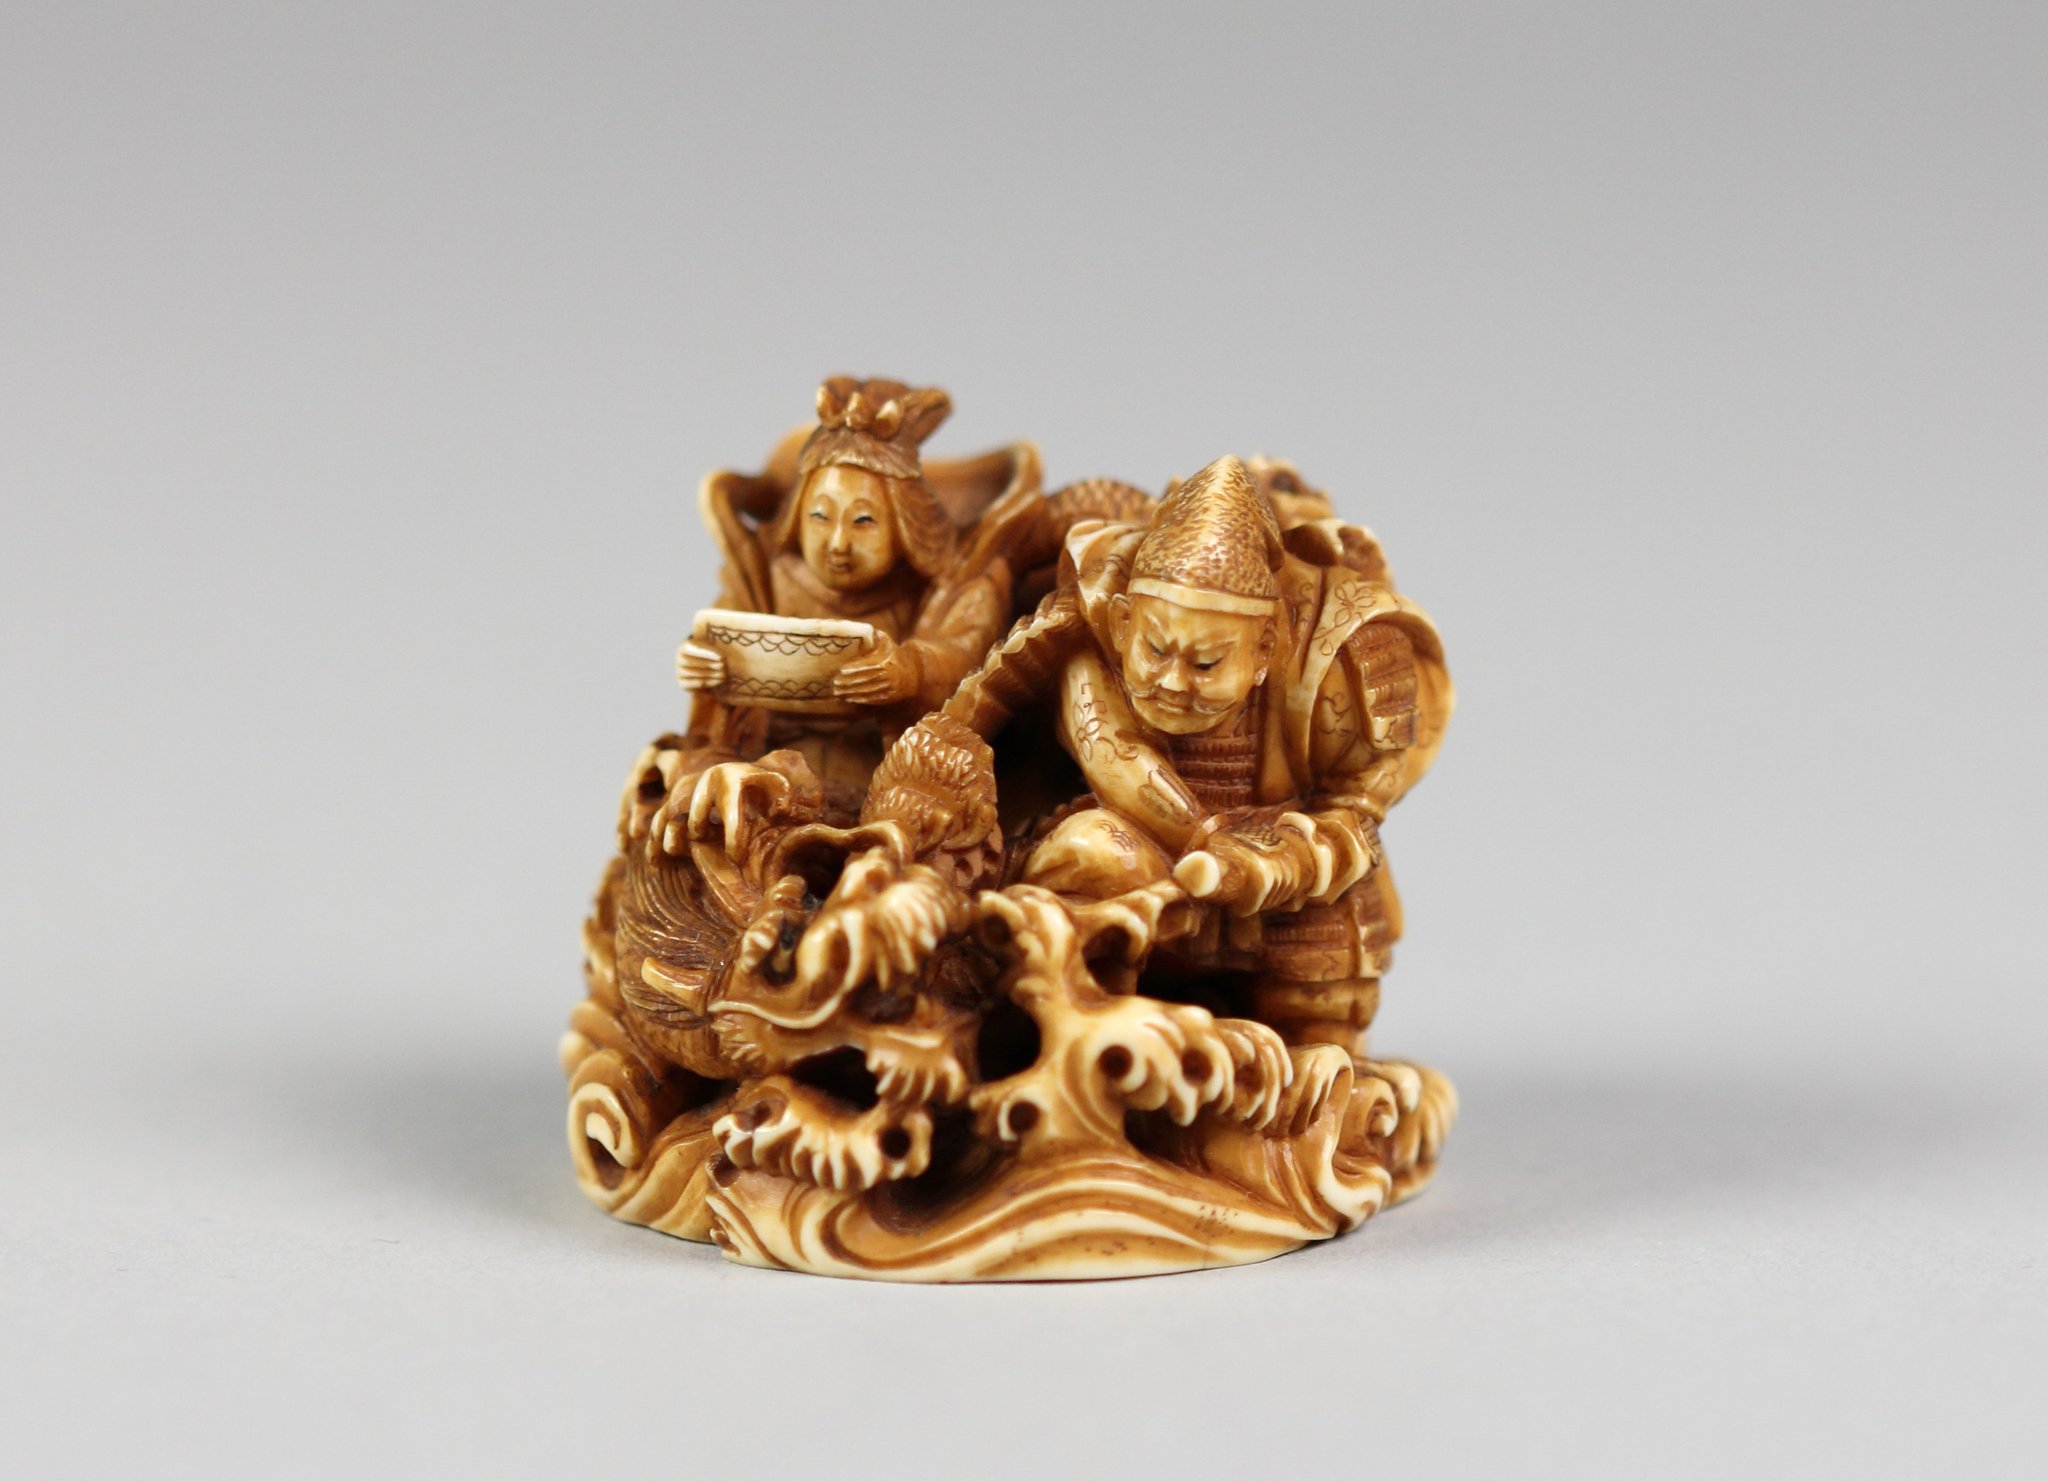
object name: netsuke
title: Netsuke of Two Seated Figures and a Dragon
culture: japanese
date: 1701-1900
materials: ivory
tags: men,women,dragons